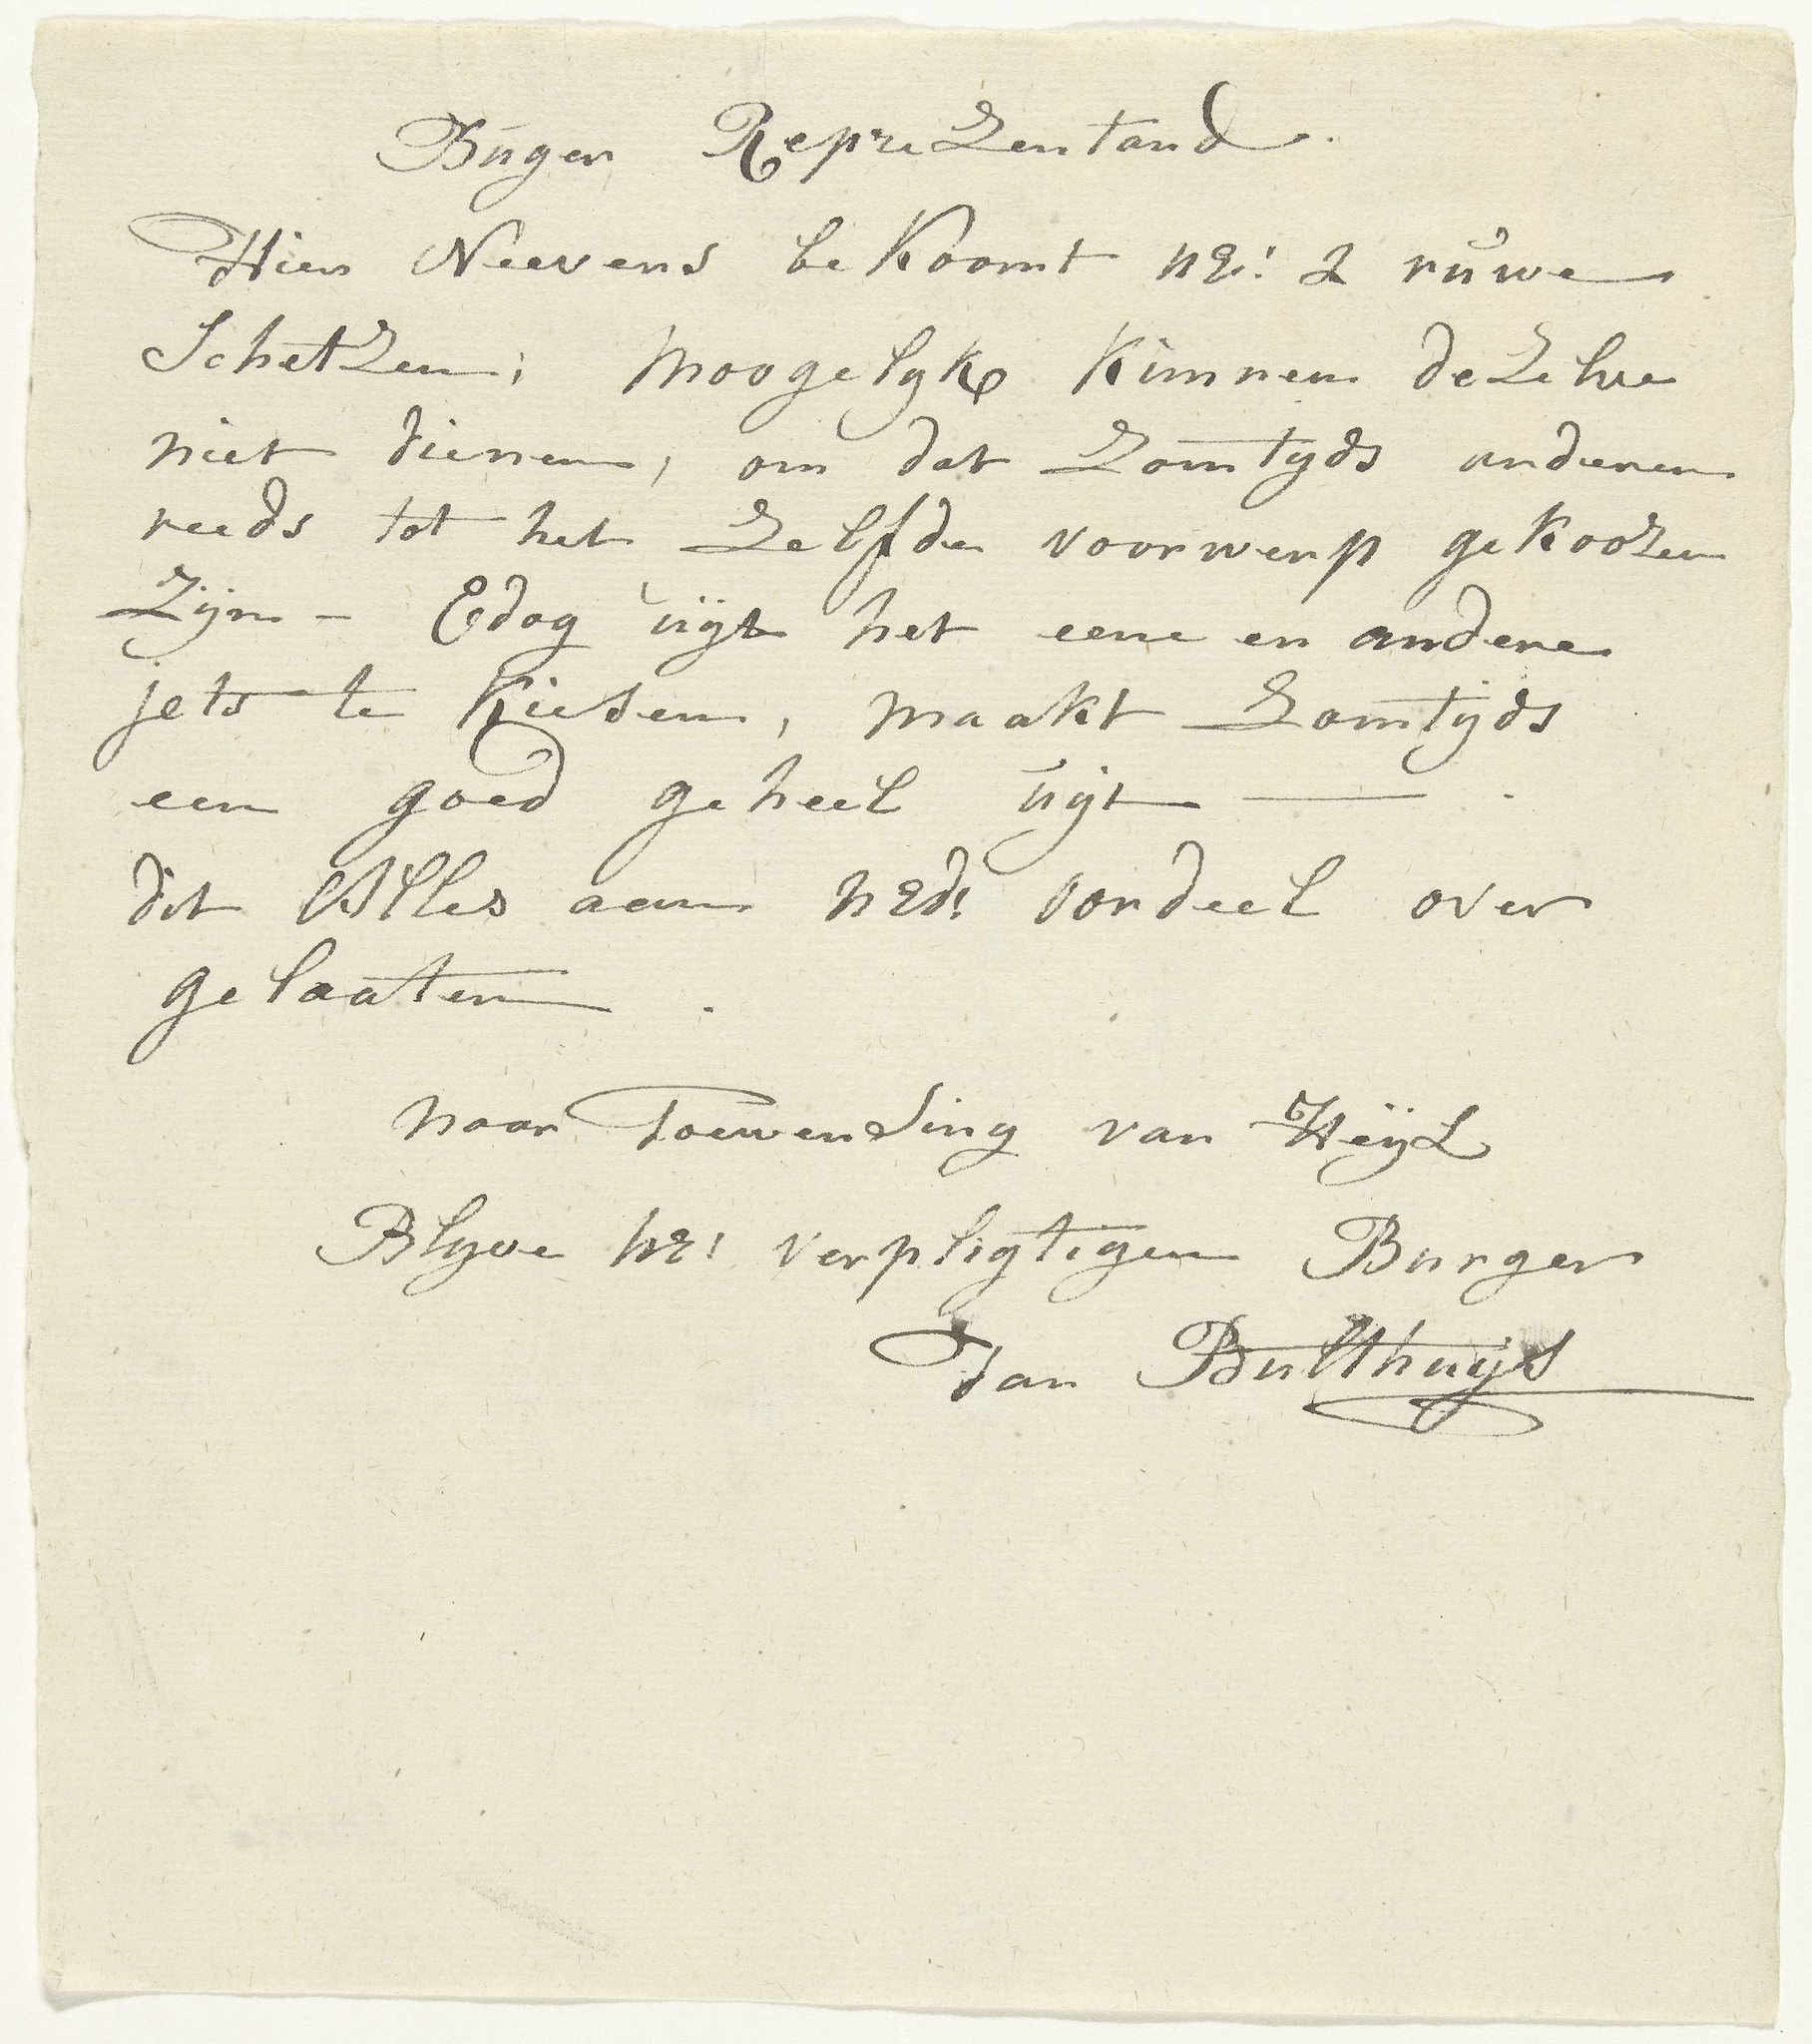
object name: letter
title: Brief van Jan Bulthuis waarin hij twee schetsen ter keuze aanbiedt, 1795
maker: jan bulthuis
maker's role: draughtsman, print maker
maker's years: 1750-1801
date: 1795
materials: paper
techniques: pen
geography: amsterdam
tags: handwriting, written text, amsterdam, alliance with france (1795)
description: Handgeschreven brief van Jan Bulthuis waarin hij de burgerrepresentant twee schetsen ter keuze aanbiedt, 1795. Ontwerpen voor de allegorische decoraties opgericht te Amsterdam bij het Alliantiefeest op 19 juni 1795.